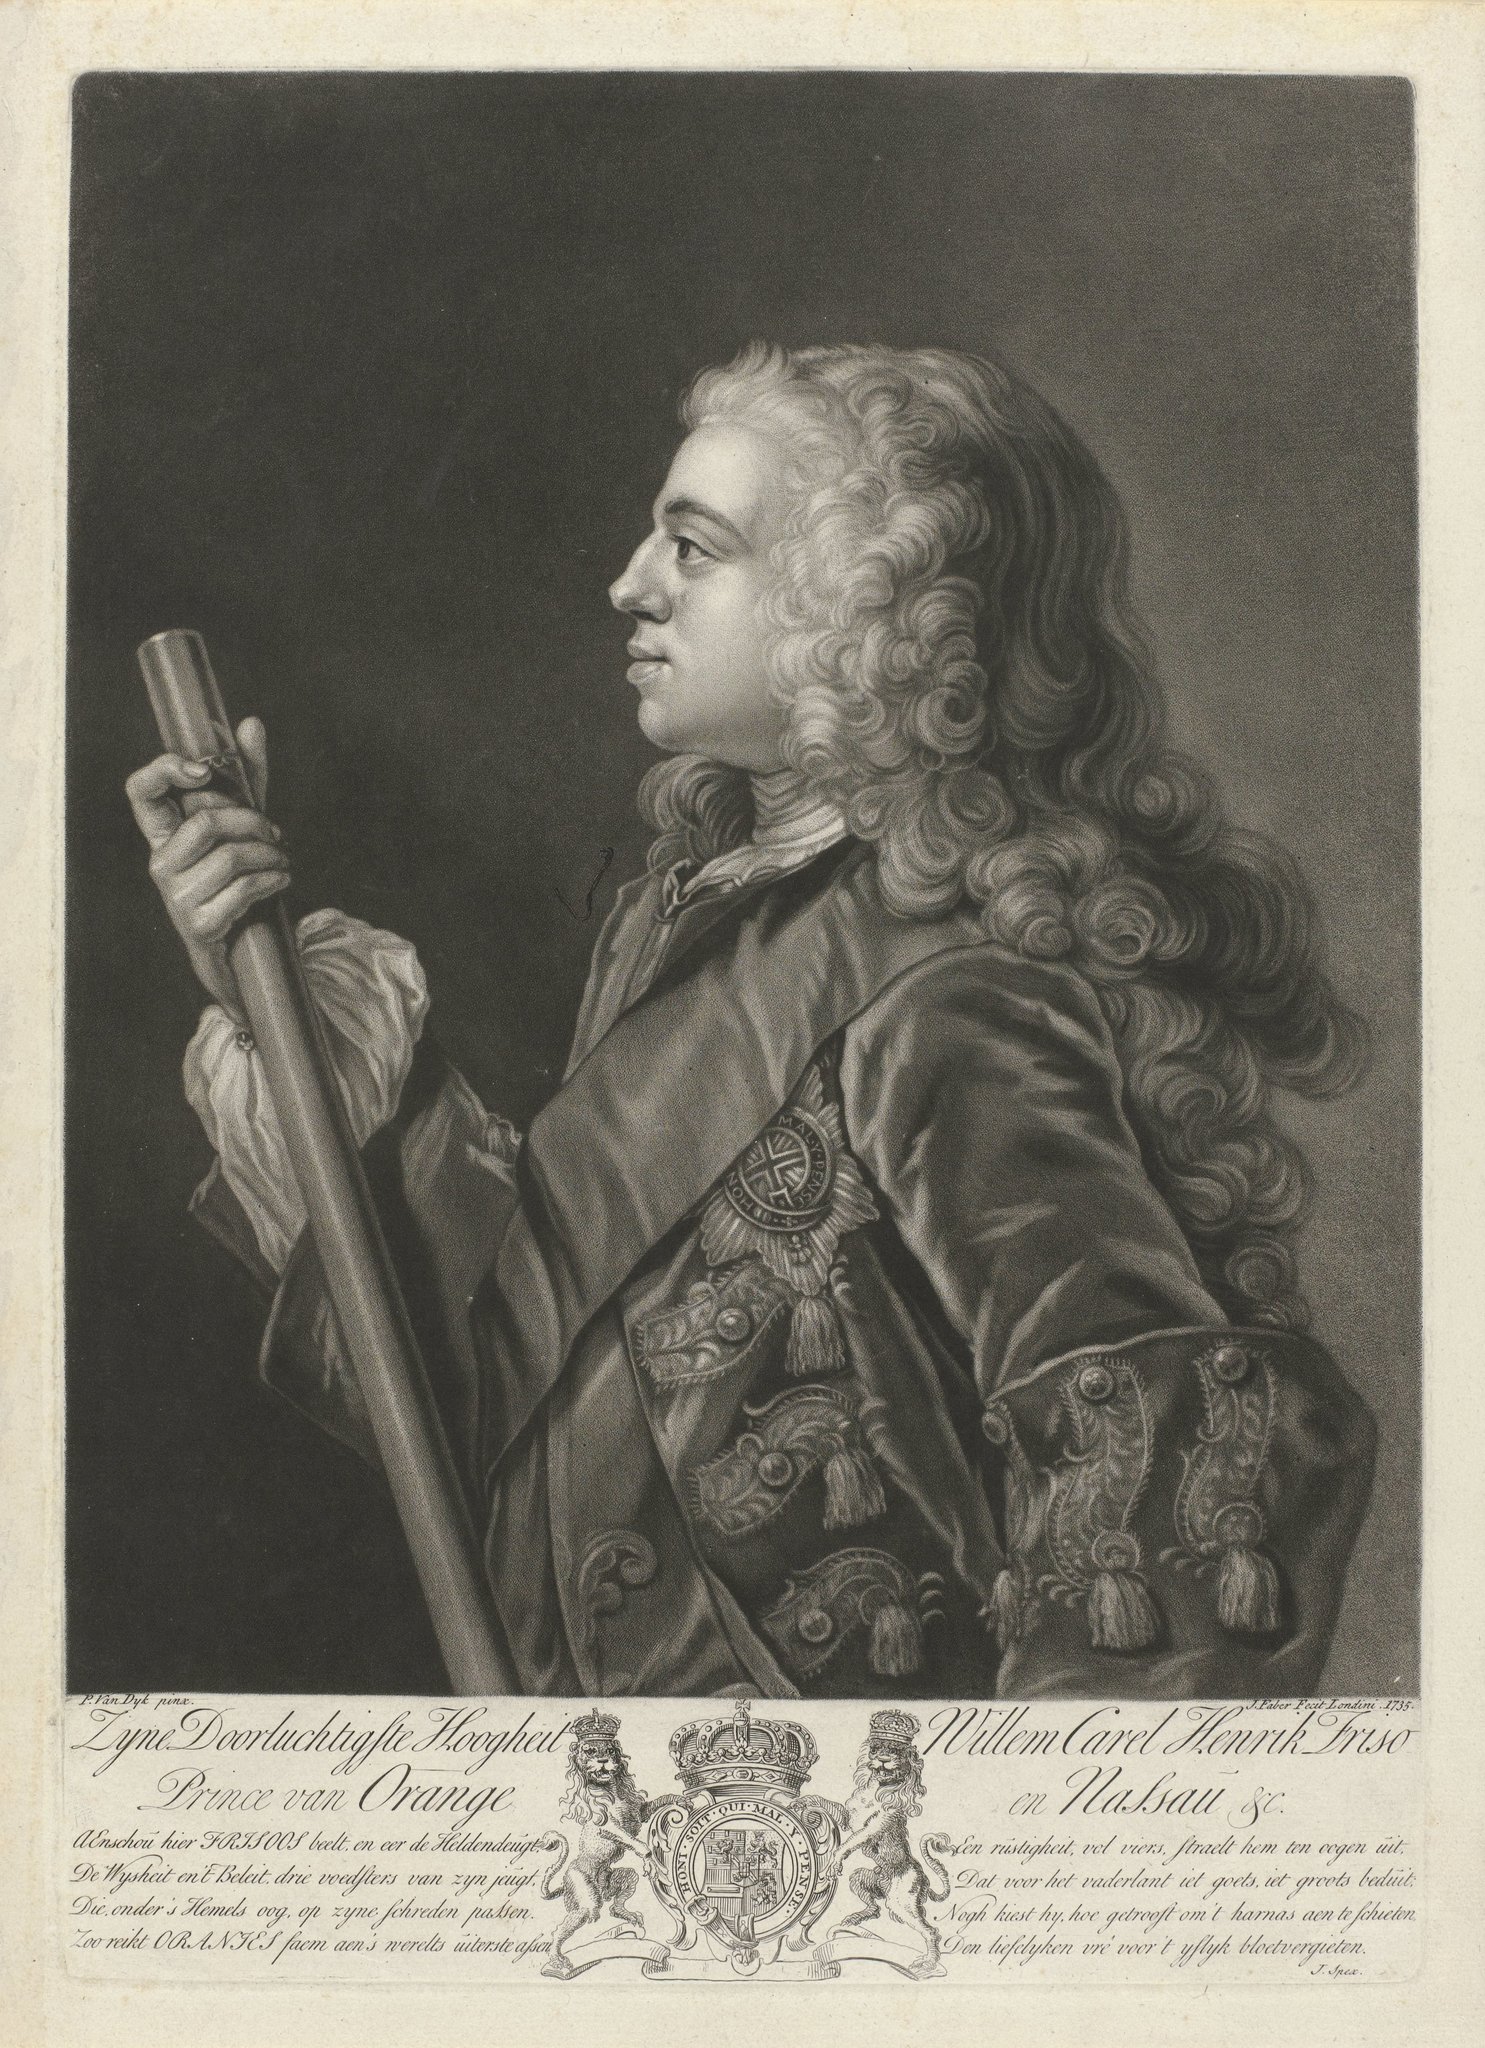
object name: print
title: Portret van Willem IV, prins van Oranje-Nassau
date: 1735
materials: paper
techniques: mezzotint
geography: london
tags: the hague, willem iv (prins van oranje-nassau), knighthood order (garter) - insignia of a knighthood order, e.g.: badge, chain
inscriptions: date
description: Portret van Willem IV. In zijn rechterhand een commandostaf. Midden onder zijn wapen met een kroon en twee leeuwen, gedecoreerd met de Kousenband en het devies van de Orde van de Kousenband. In de ondermarge zijn naam, zijn titels en twee kolommen met elk vier regels Nederlandse tekst.